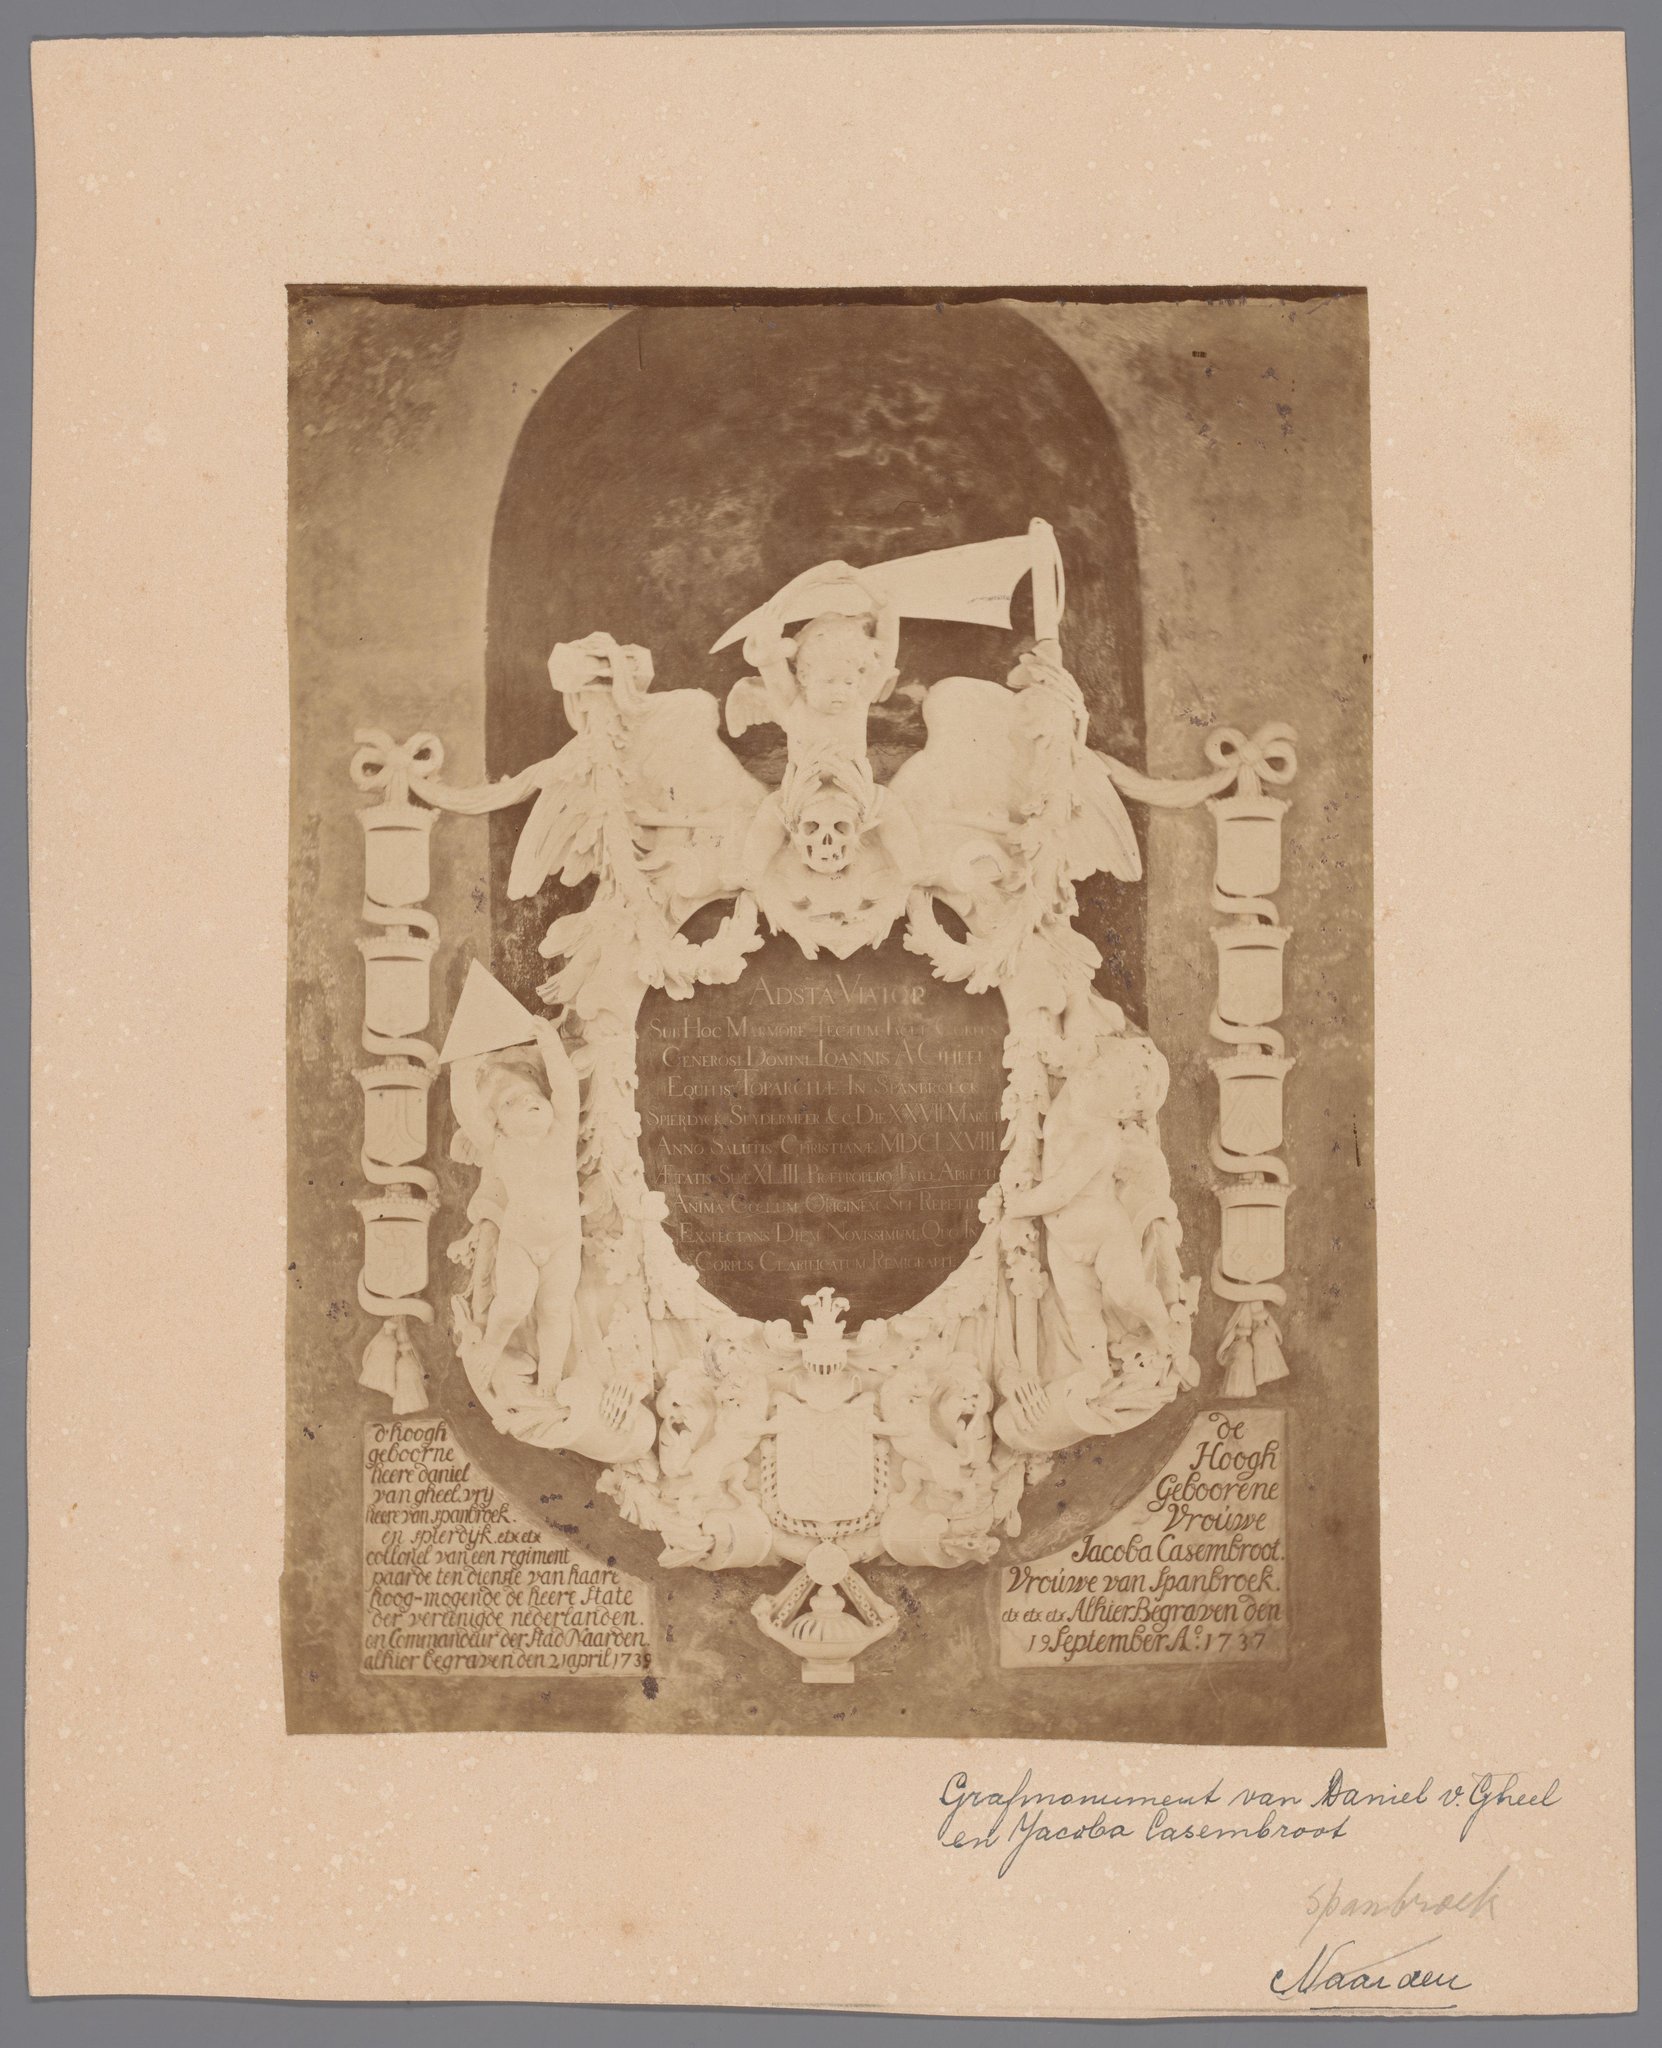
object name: photograph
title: Grafmonument van Johannes van Gheel, Daniël van Gheel en Jacoba Casembroot in de Hervormde Kerk van Spanbroek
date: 1890-1910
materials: cardboard, photographic support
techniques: albumen print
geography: spanbroek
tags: amsterdam, piece of sculpture, reproduction of a piece of sculpture, grave-building, monumental tomb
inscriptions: annotation: ‘Grafmonument van Daniel v. Gheel en Jacoba Casembrood/ Spanbroek/ -Naarden-’, number: ‘'11.3911’, collector's mark: ‘R:MUS.’ Lugt 2228, annotation: ‘R. [...]’, annotation: ‘# géén inv. nr. prenten!’